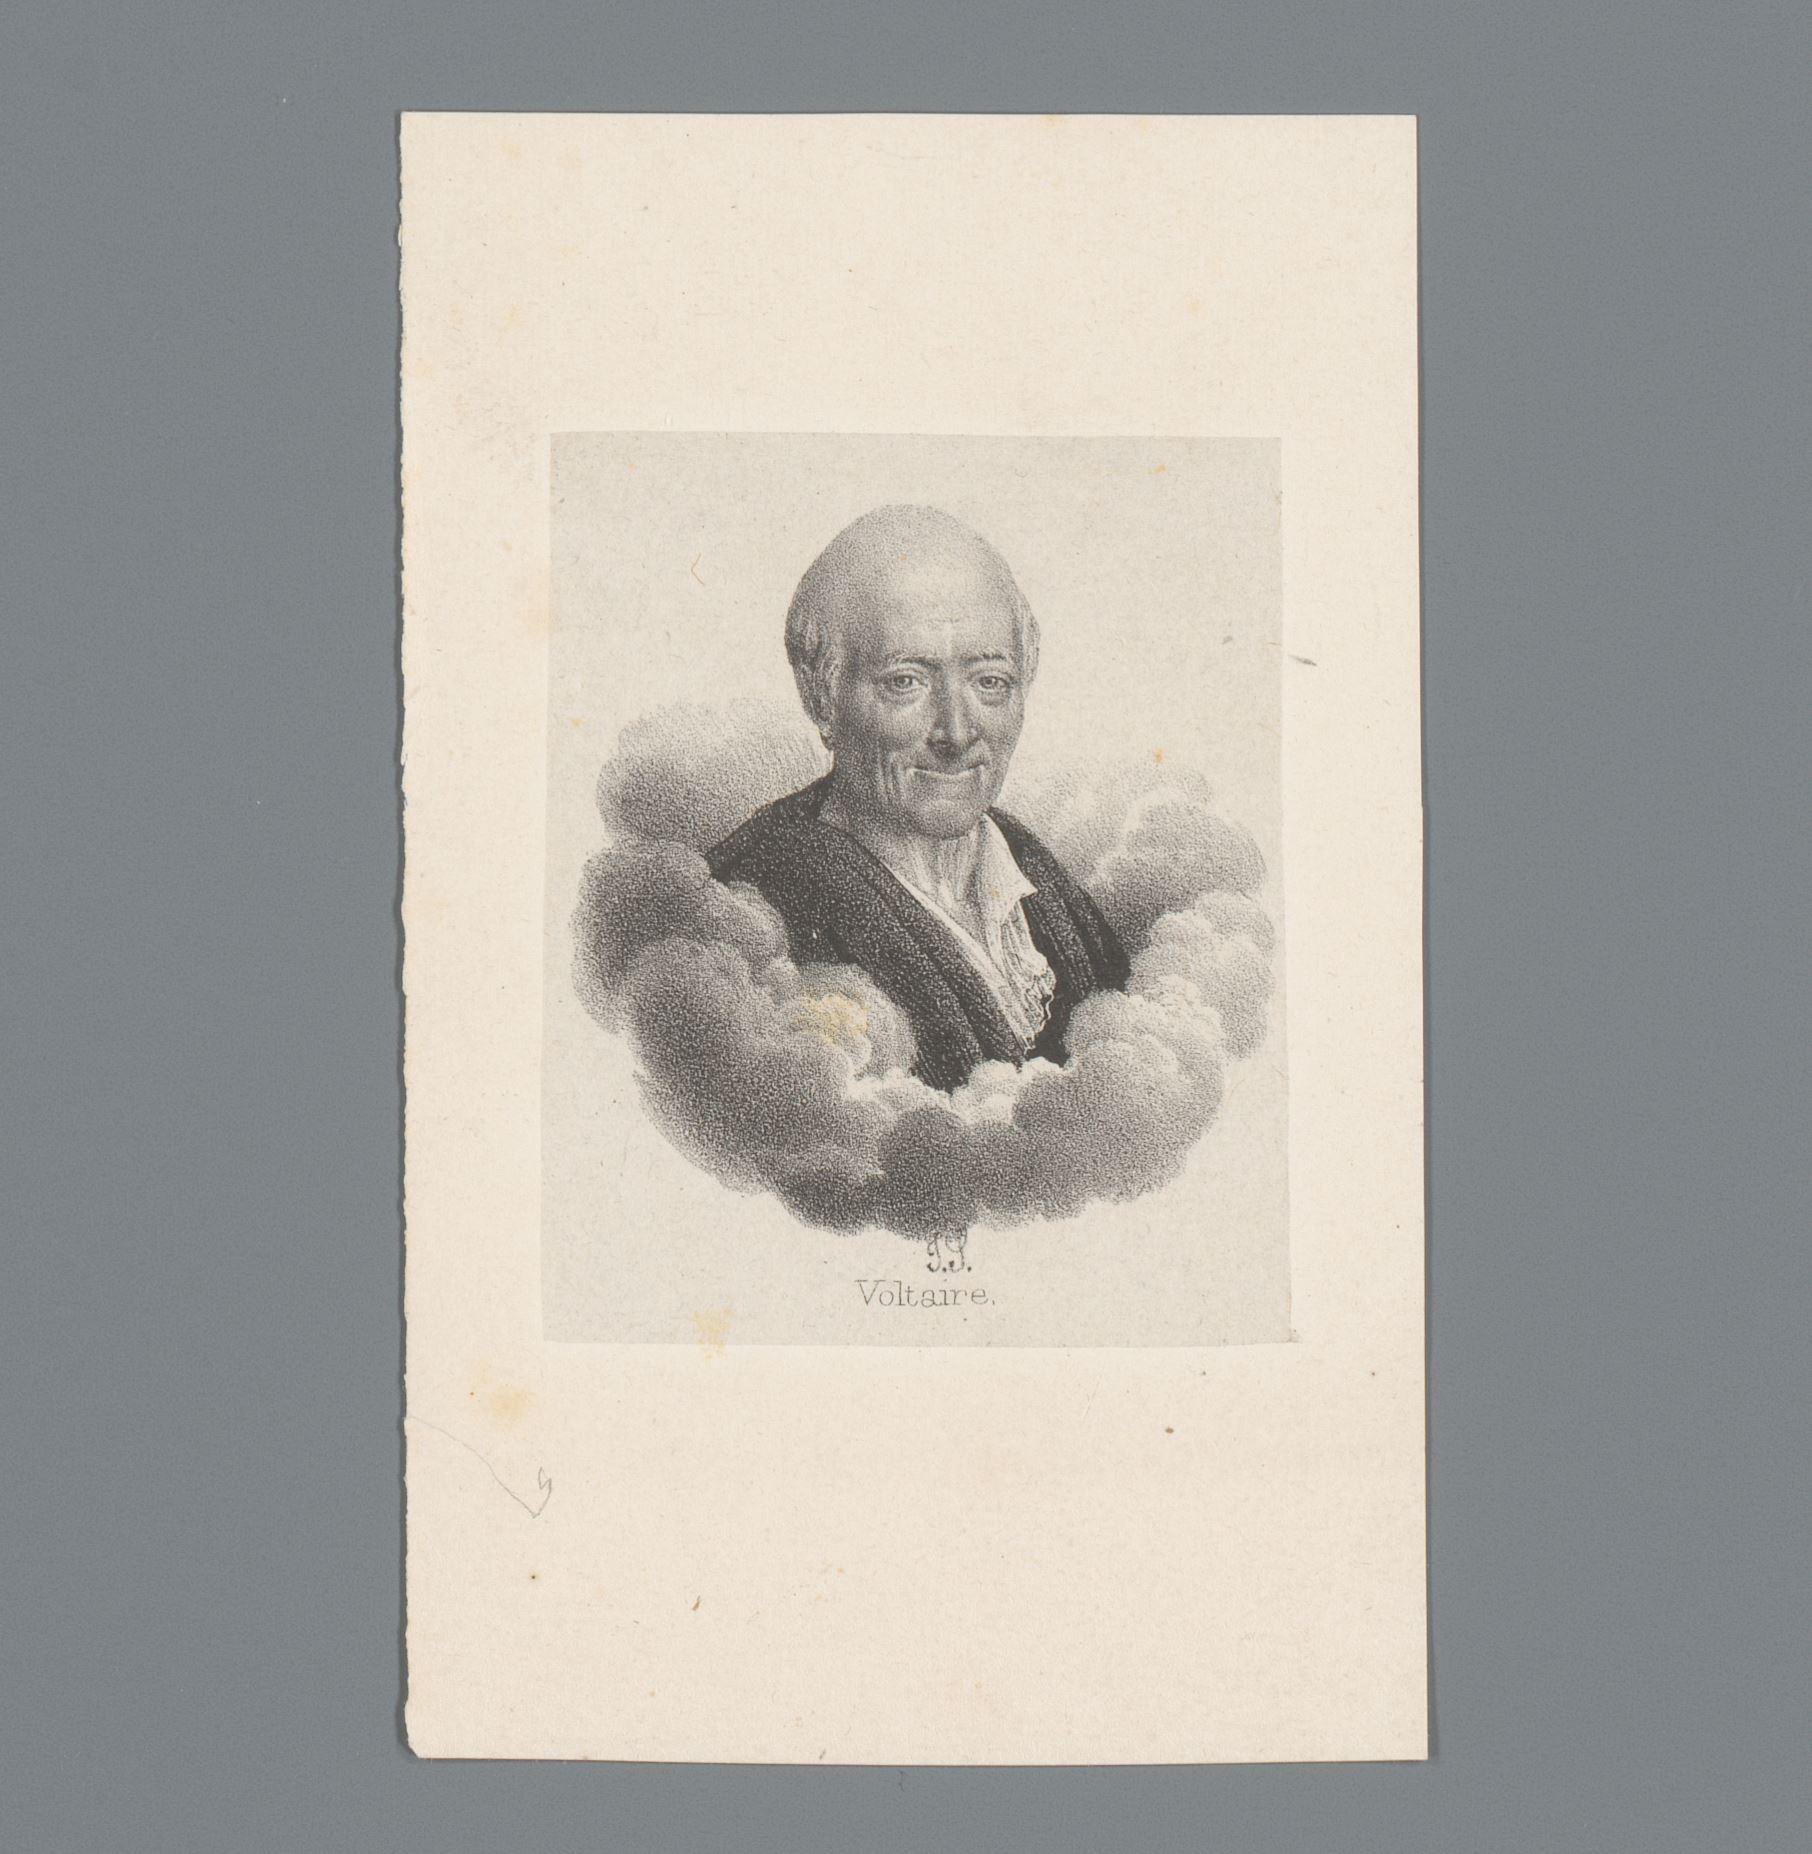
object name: print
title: Portret van Voltaire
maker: joseph schubert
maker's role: print maker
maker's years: 1816-1885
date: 1841-1885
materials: paper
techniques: lithograph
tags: paris, voltaire, historical persons, portrait of a writer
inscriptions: collector's mark: Lugt 2228